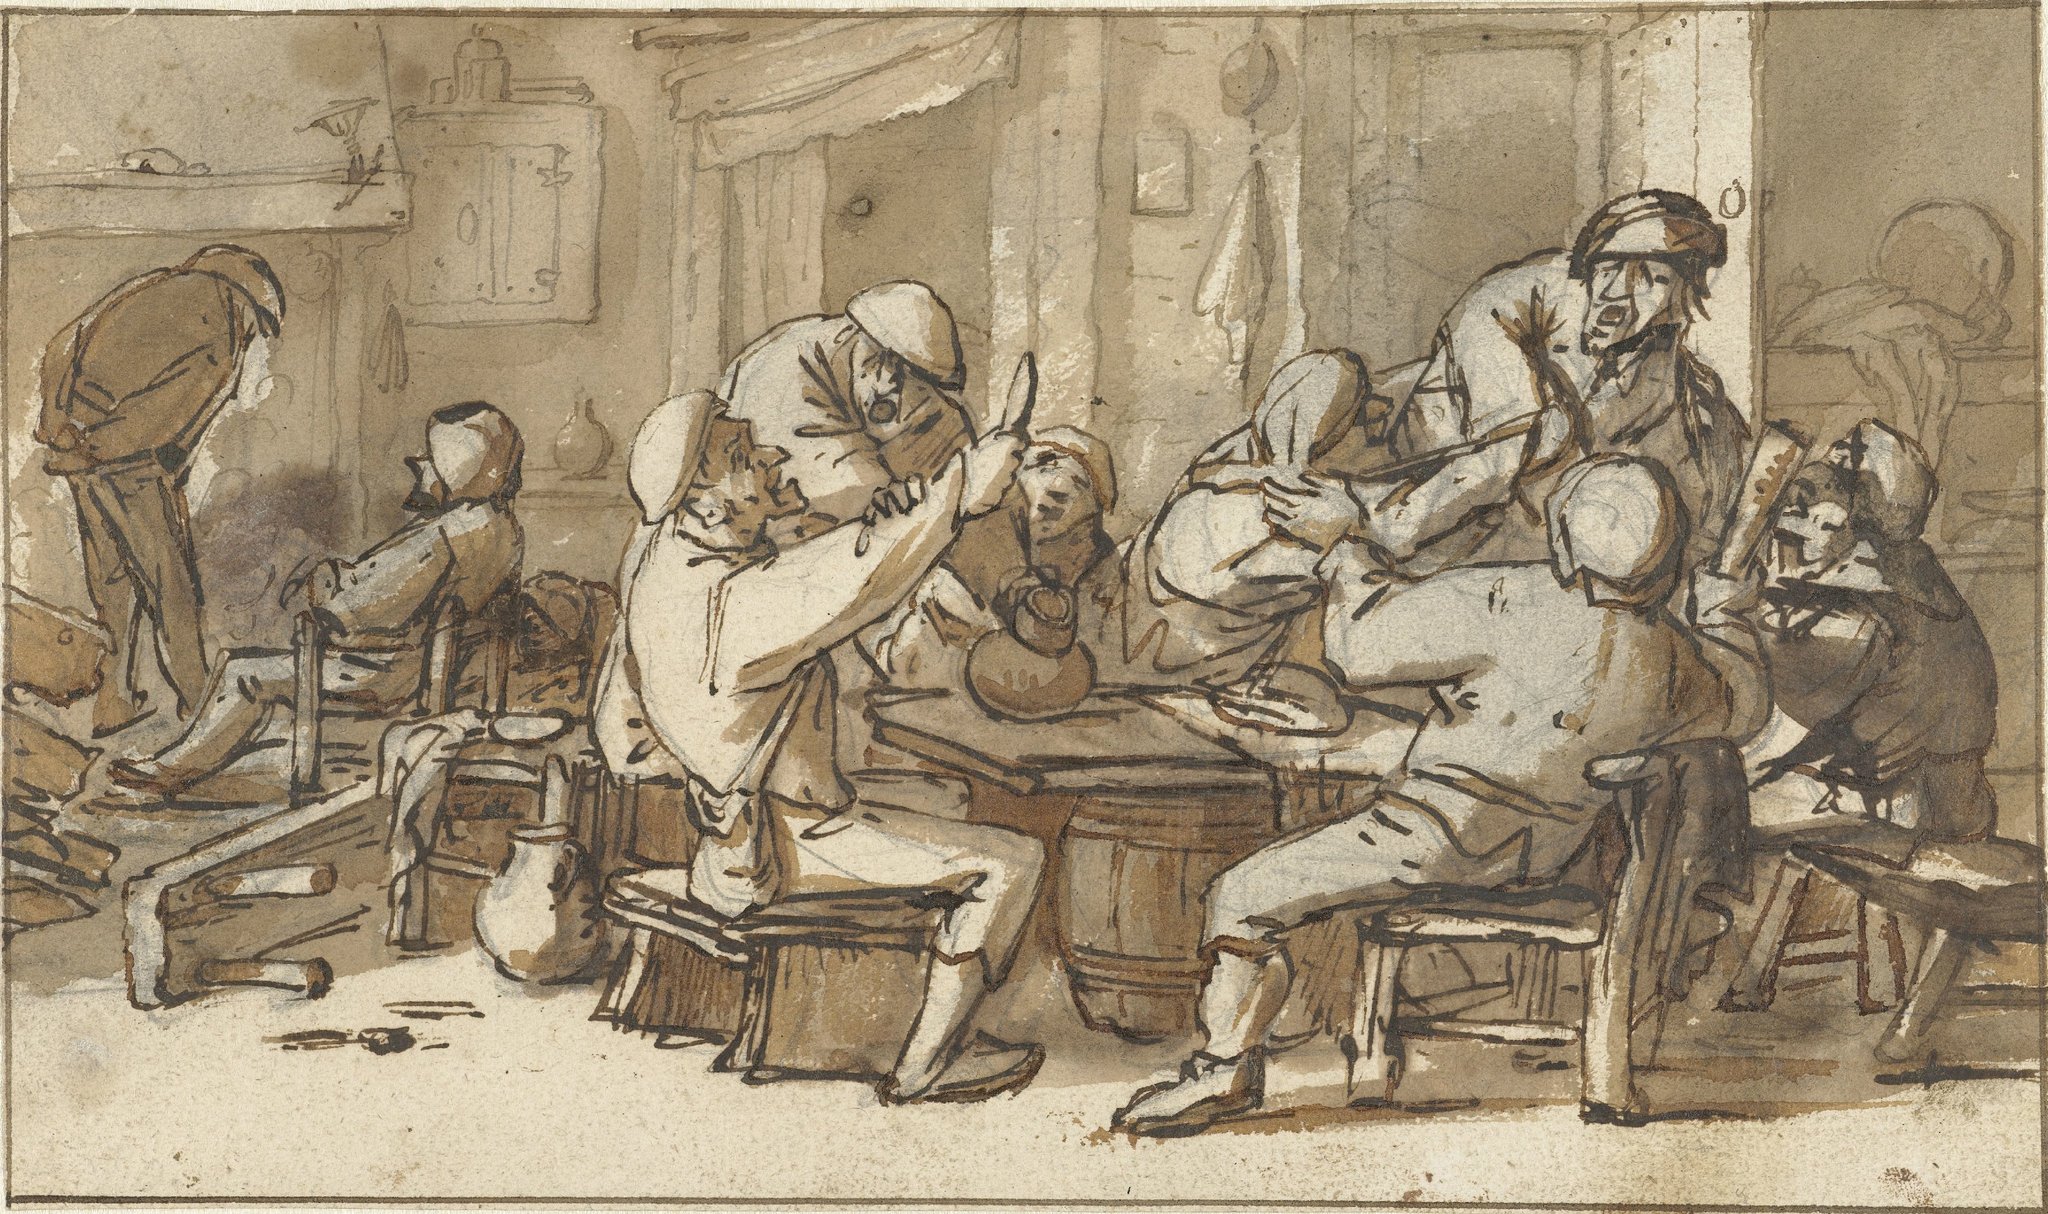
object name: drawing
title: Interieur van een herberg met drinkende en ruziemakende boeren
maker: jan havicksz. steen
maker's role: painter, print maker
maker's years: 1625-1679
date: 1620-1685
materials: ink, paper, pencil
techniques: brush, pen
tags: inn, coffee-house, public house, etc., drunken brawl (usually peasants fighting in an inn)